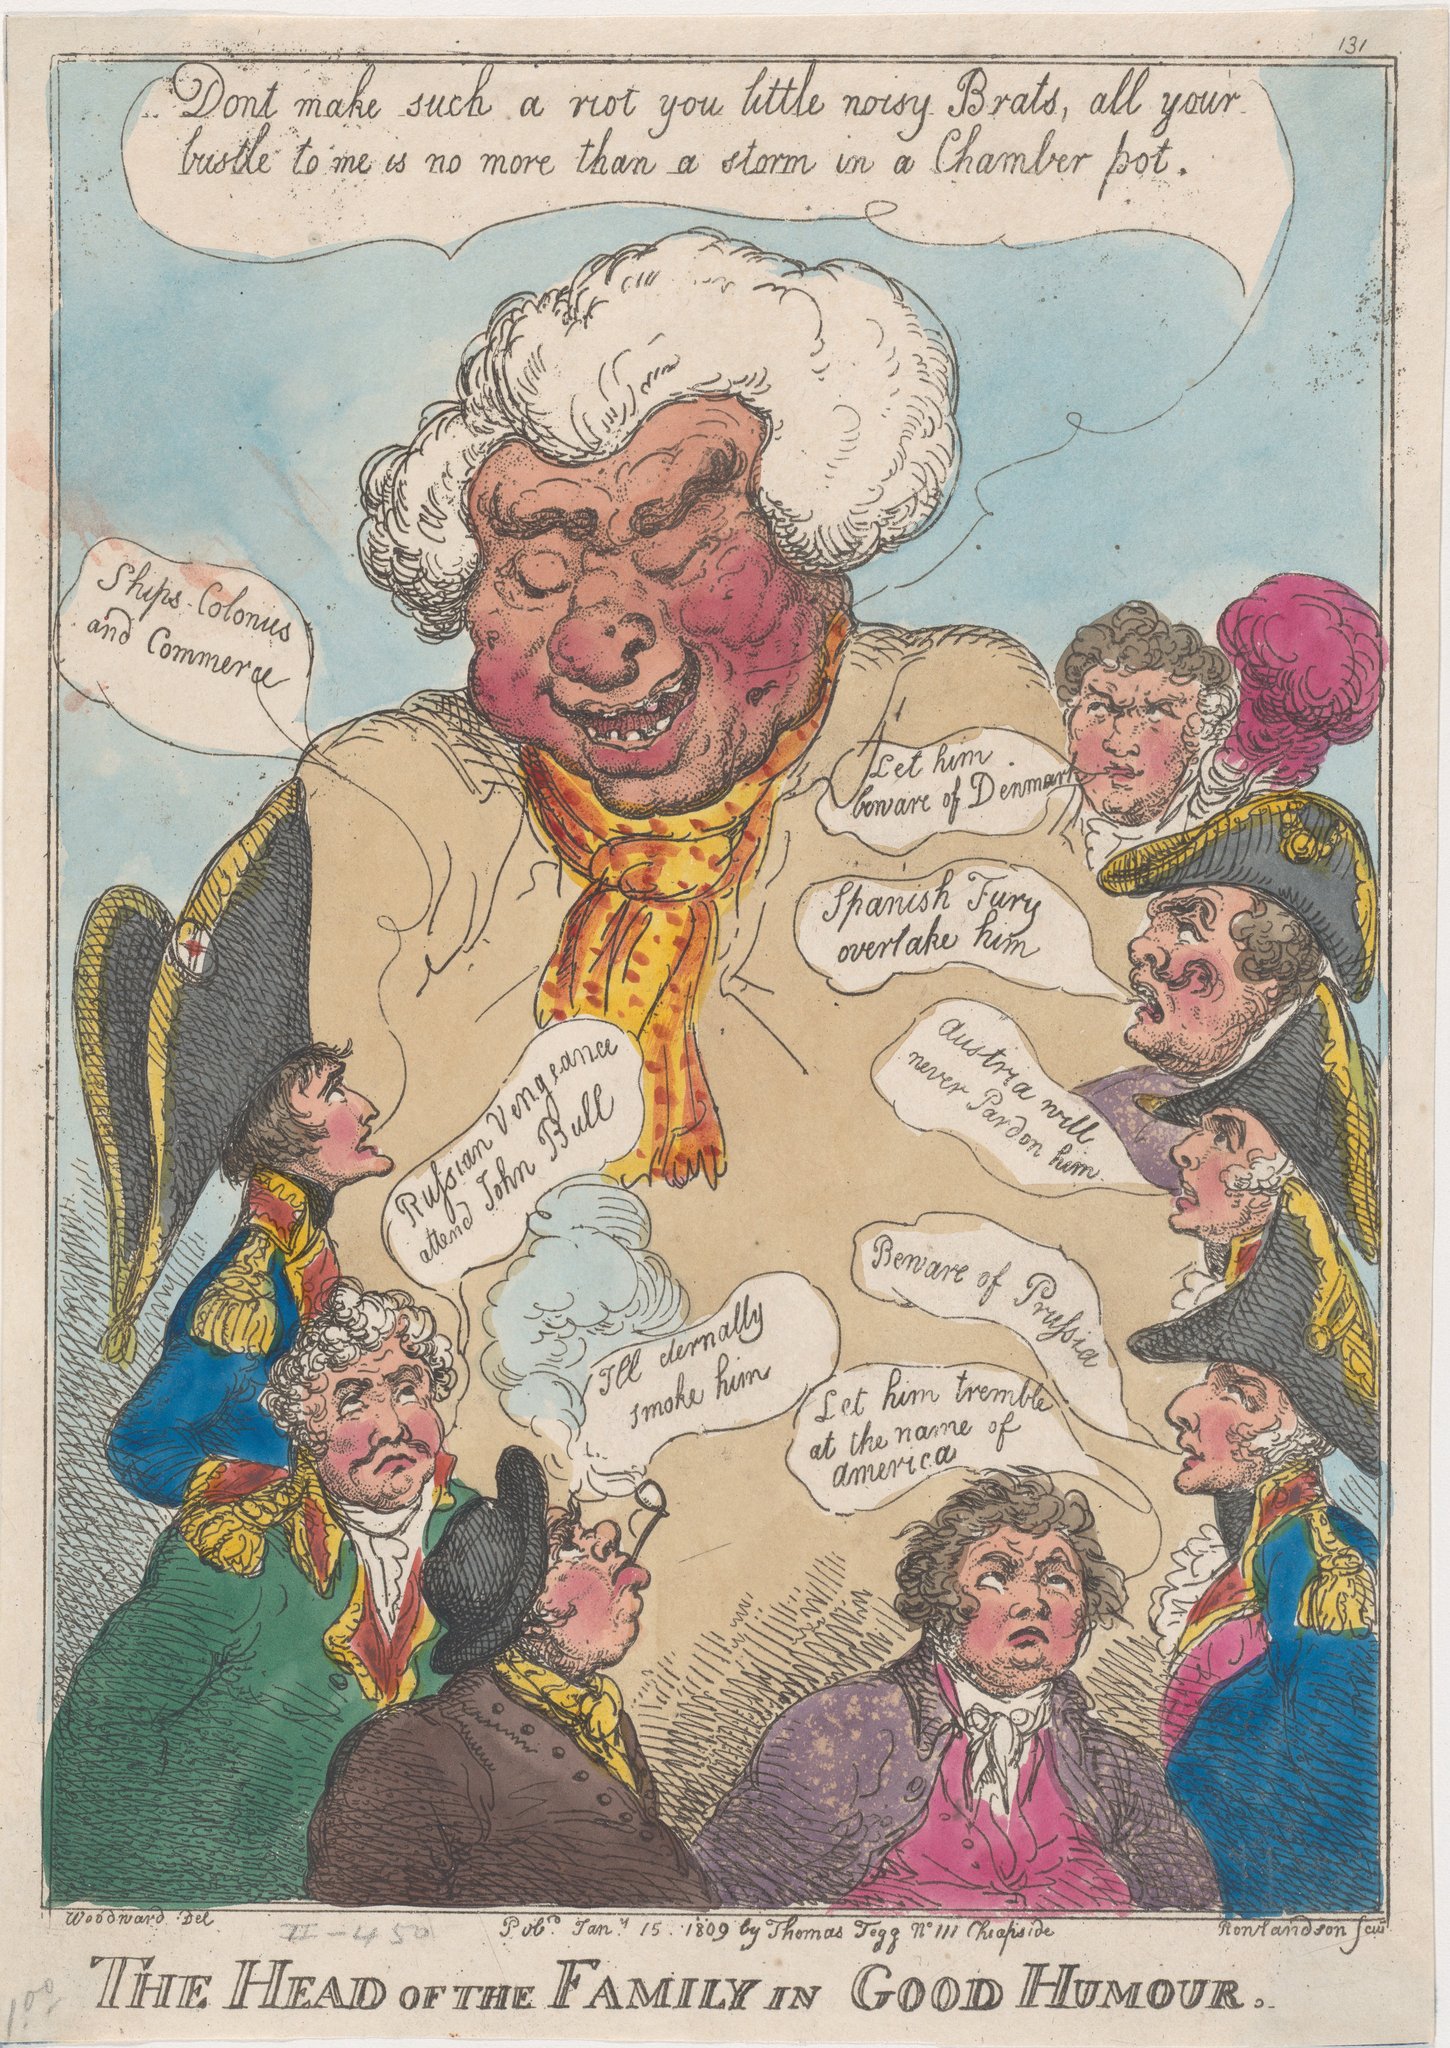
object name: print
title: The Head of the Family in Good Humour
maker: thomas rowlandson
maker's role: artist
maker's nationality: british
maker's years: 1757-1827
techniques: etching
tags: satire,men,caricature,politics